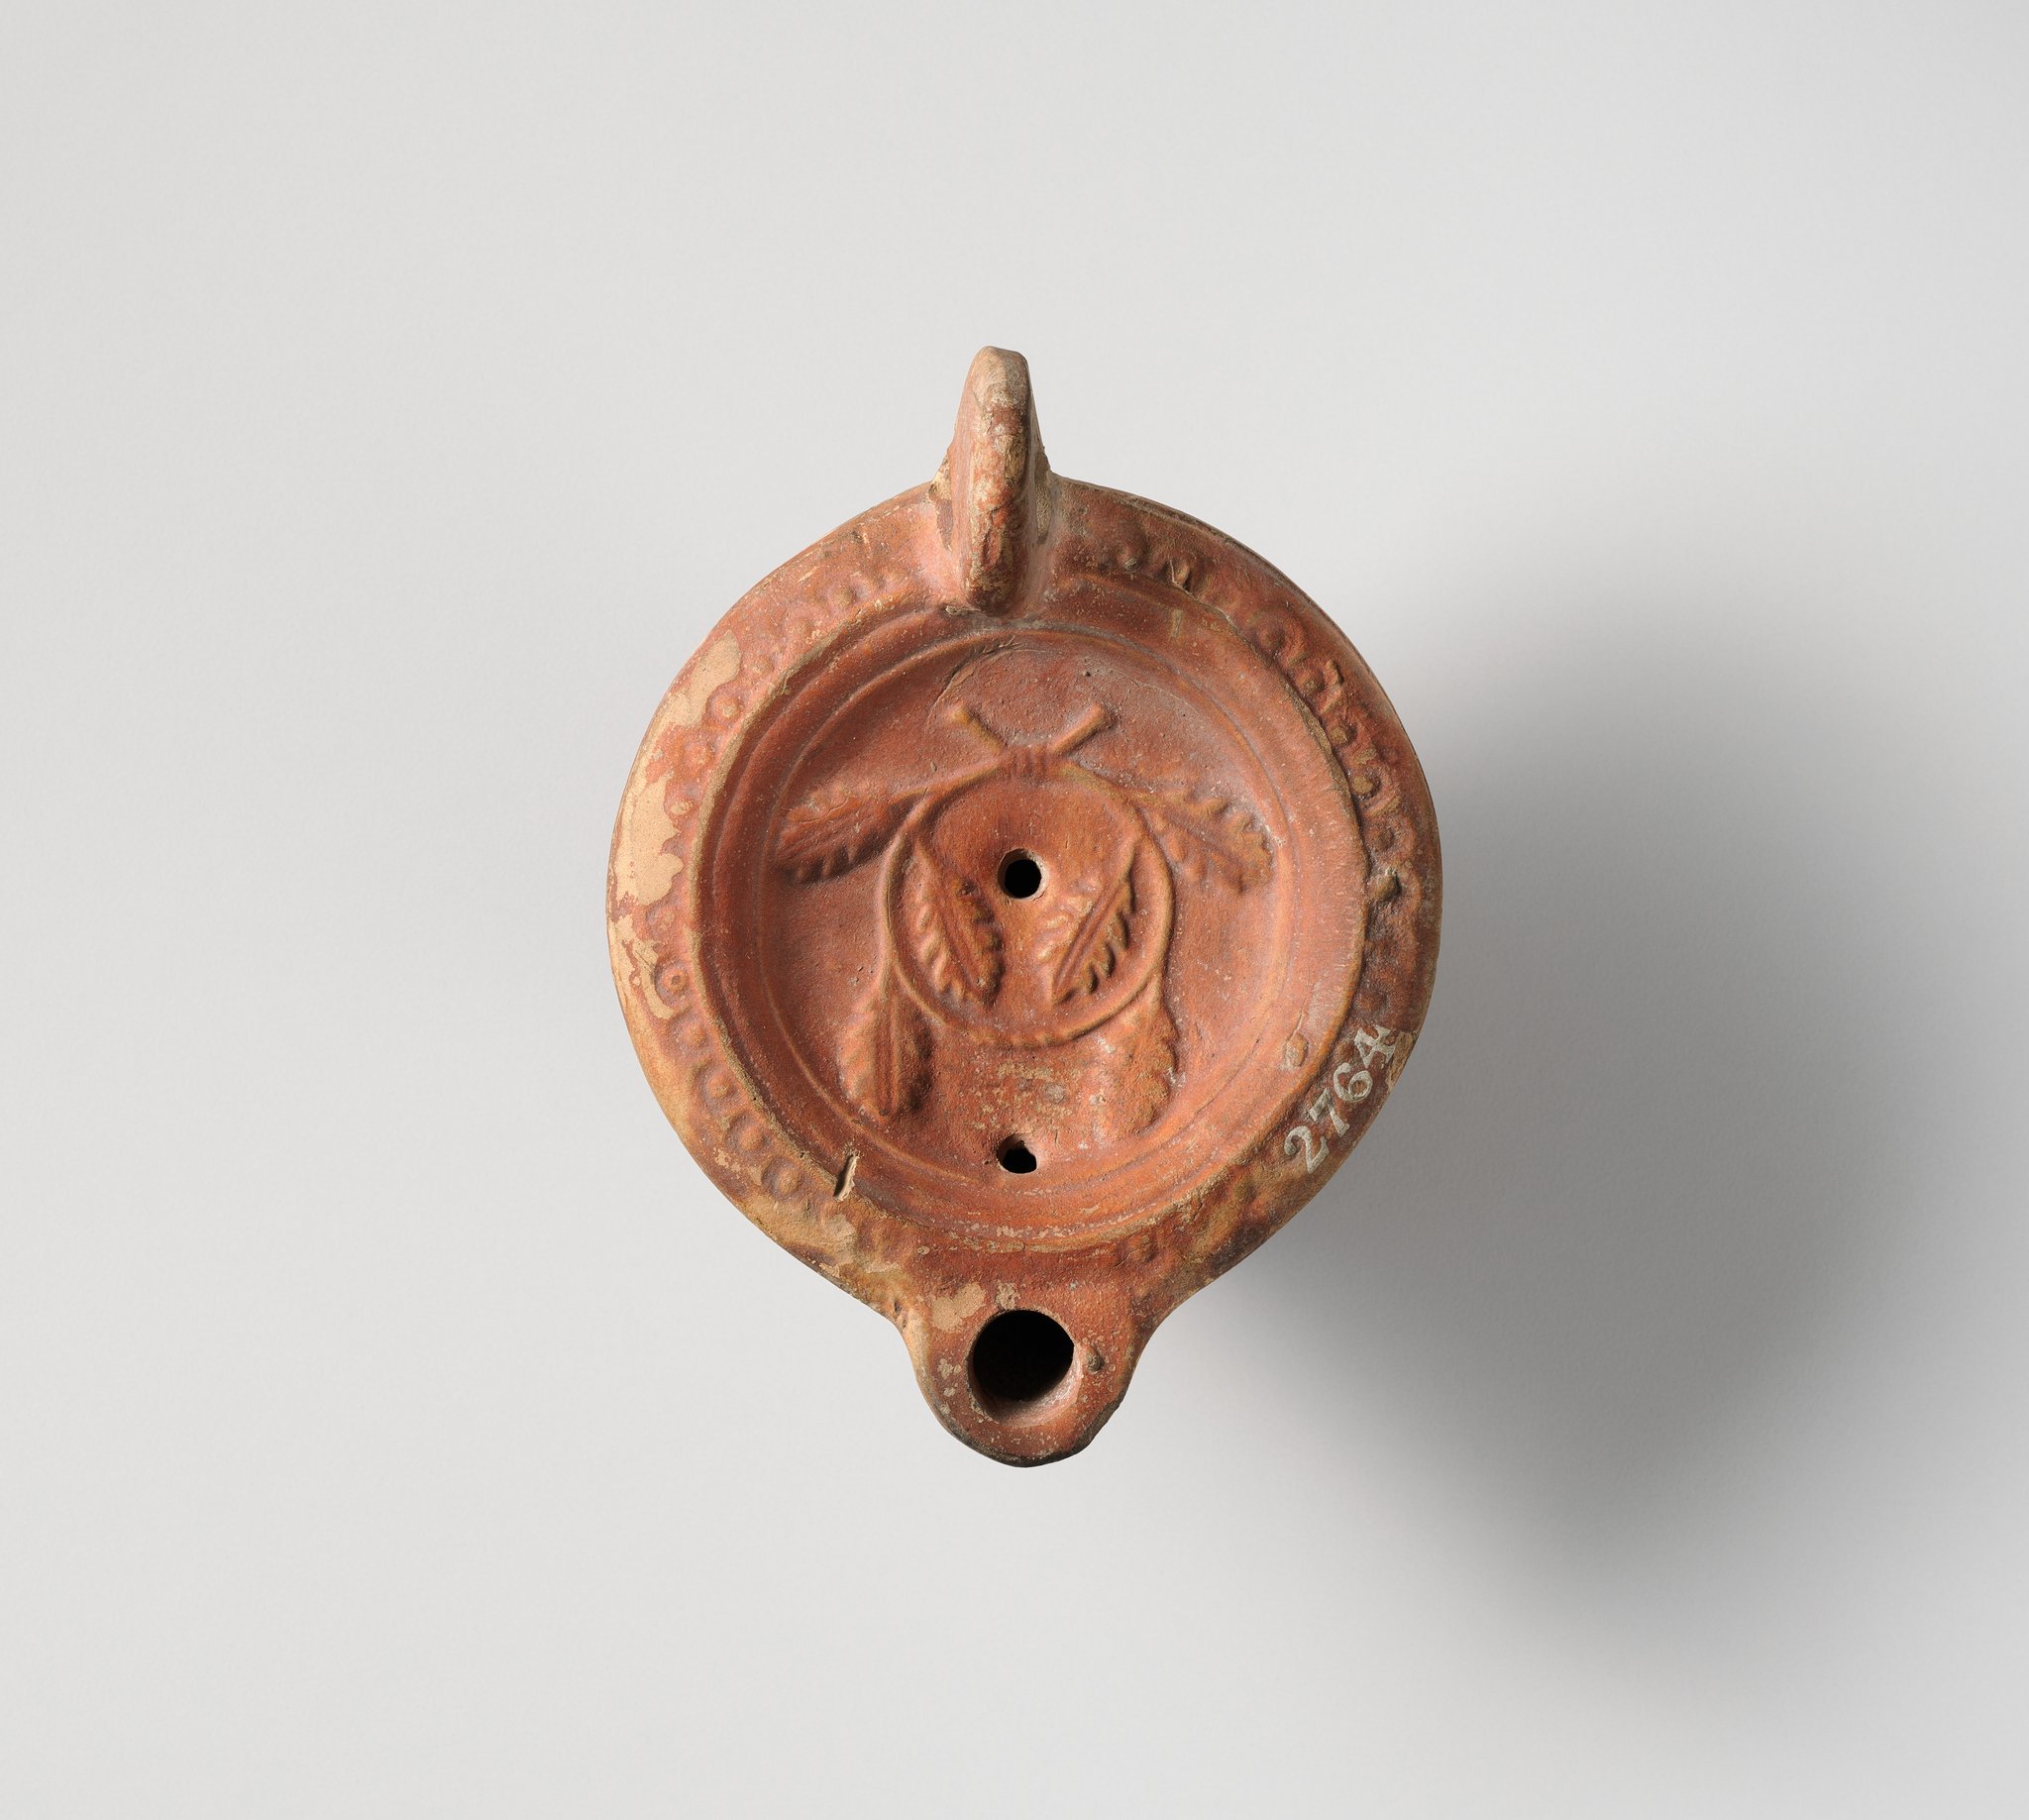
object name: lamp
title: Terracotta oil lamp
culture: roman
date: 101-200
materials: terracotta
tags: leaves